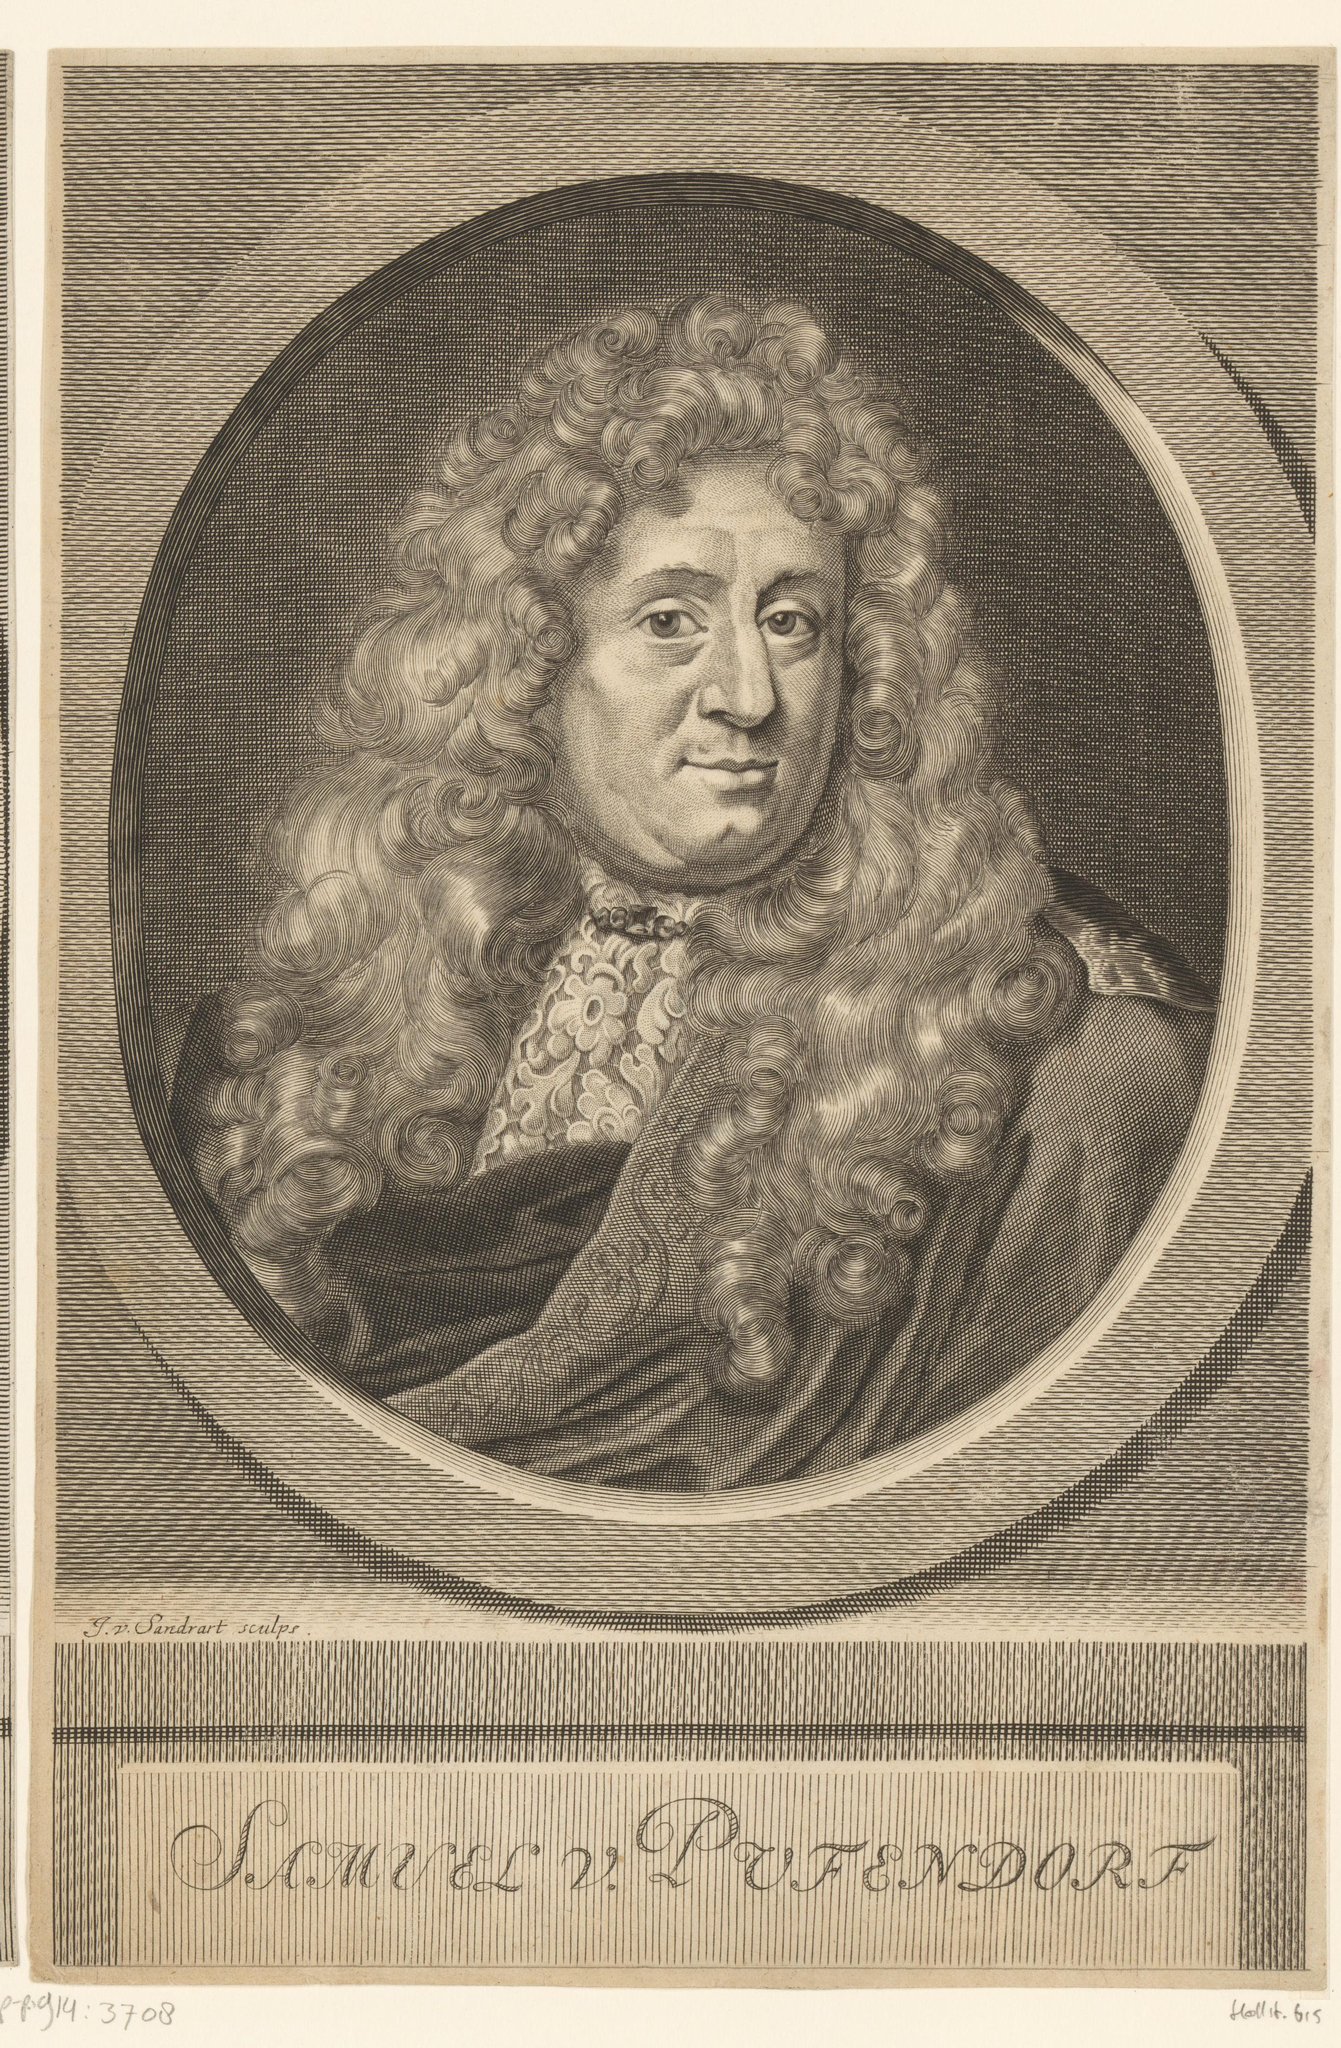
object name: print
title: Portret van Samuel von Pufendorf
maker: jakob von sandrart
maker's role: print maker, publisher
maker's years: 1630-1708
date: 1688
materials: paper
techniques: engraving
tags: historical persons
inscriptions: collector's mark: Lugt 2228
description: Prent ook gebruikt in: Pufendorf, Samuel von. Sechs und Zwantzig Bücher der Schwedisch- und Deutschen Kriegs-Geschichte. Frankfurt am Main: J.F. Gleditsch, 1688.